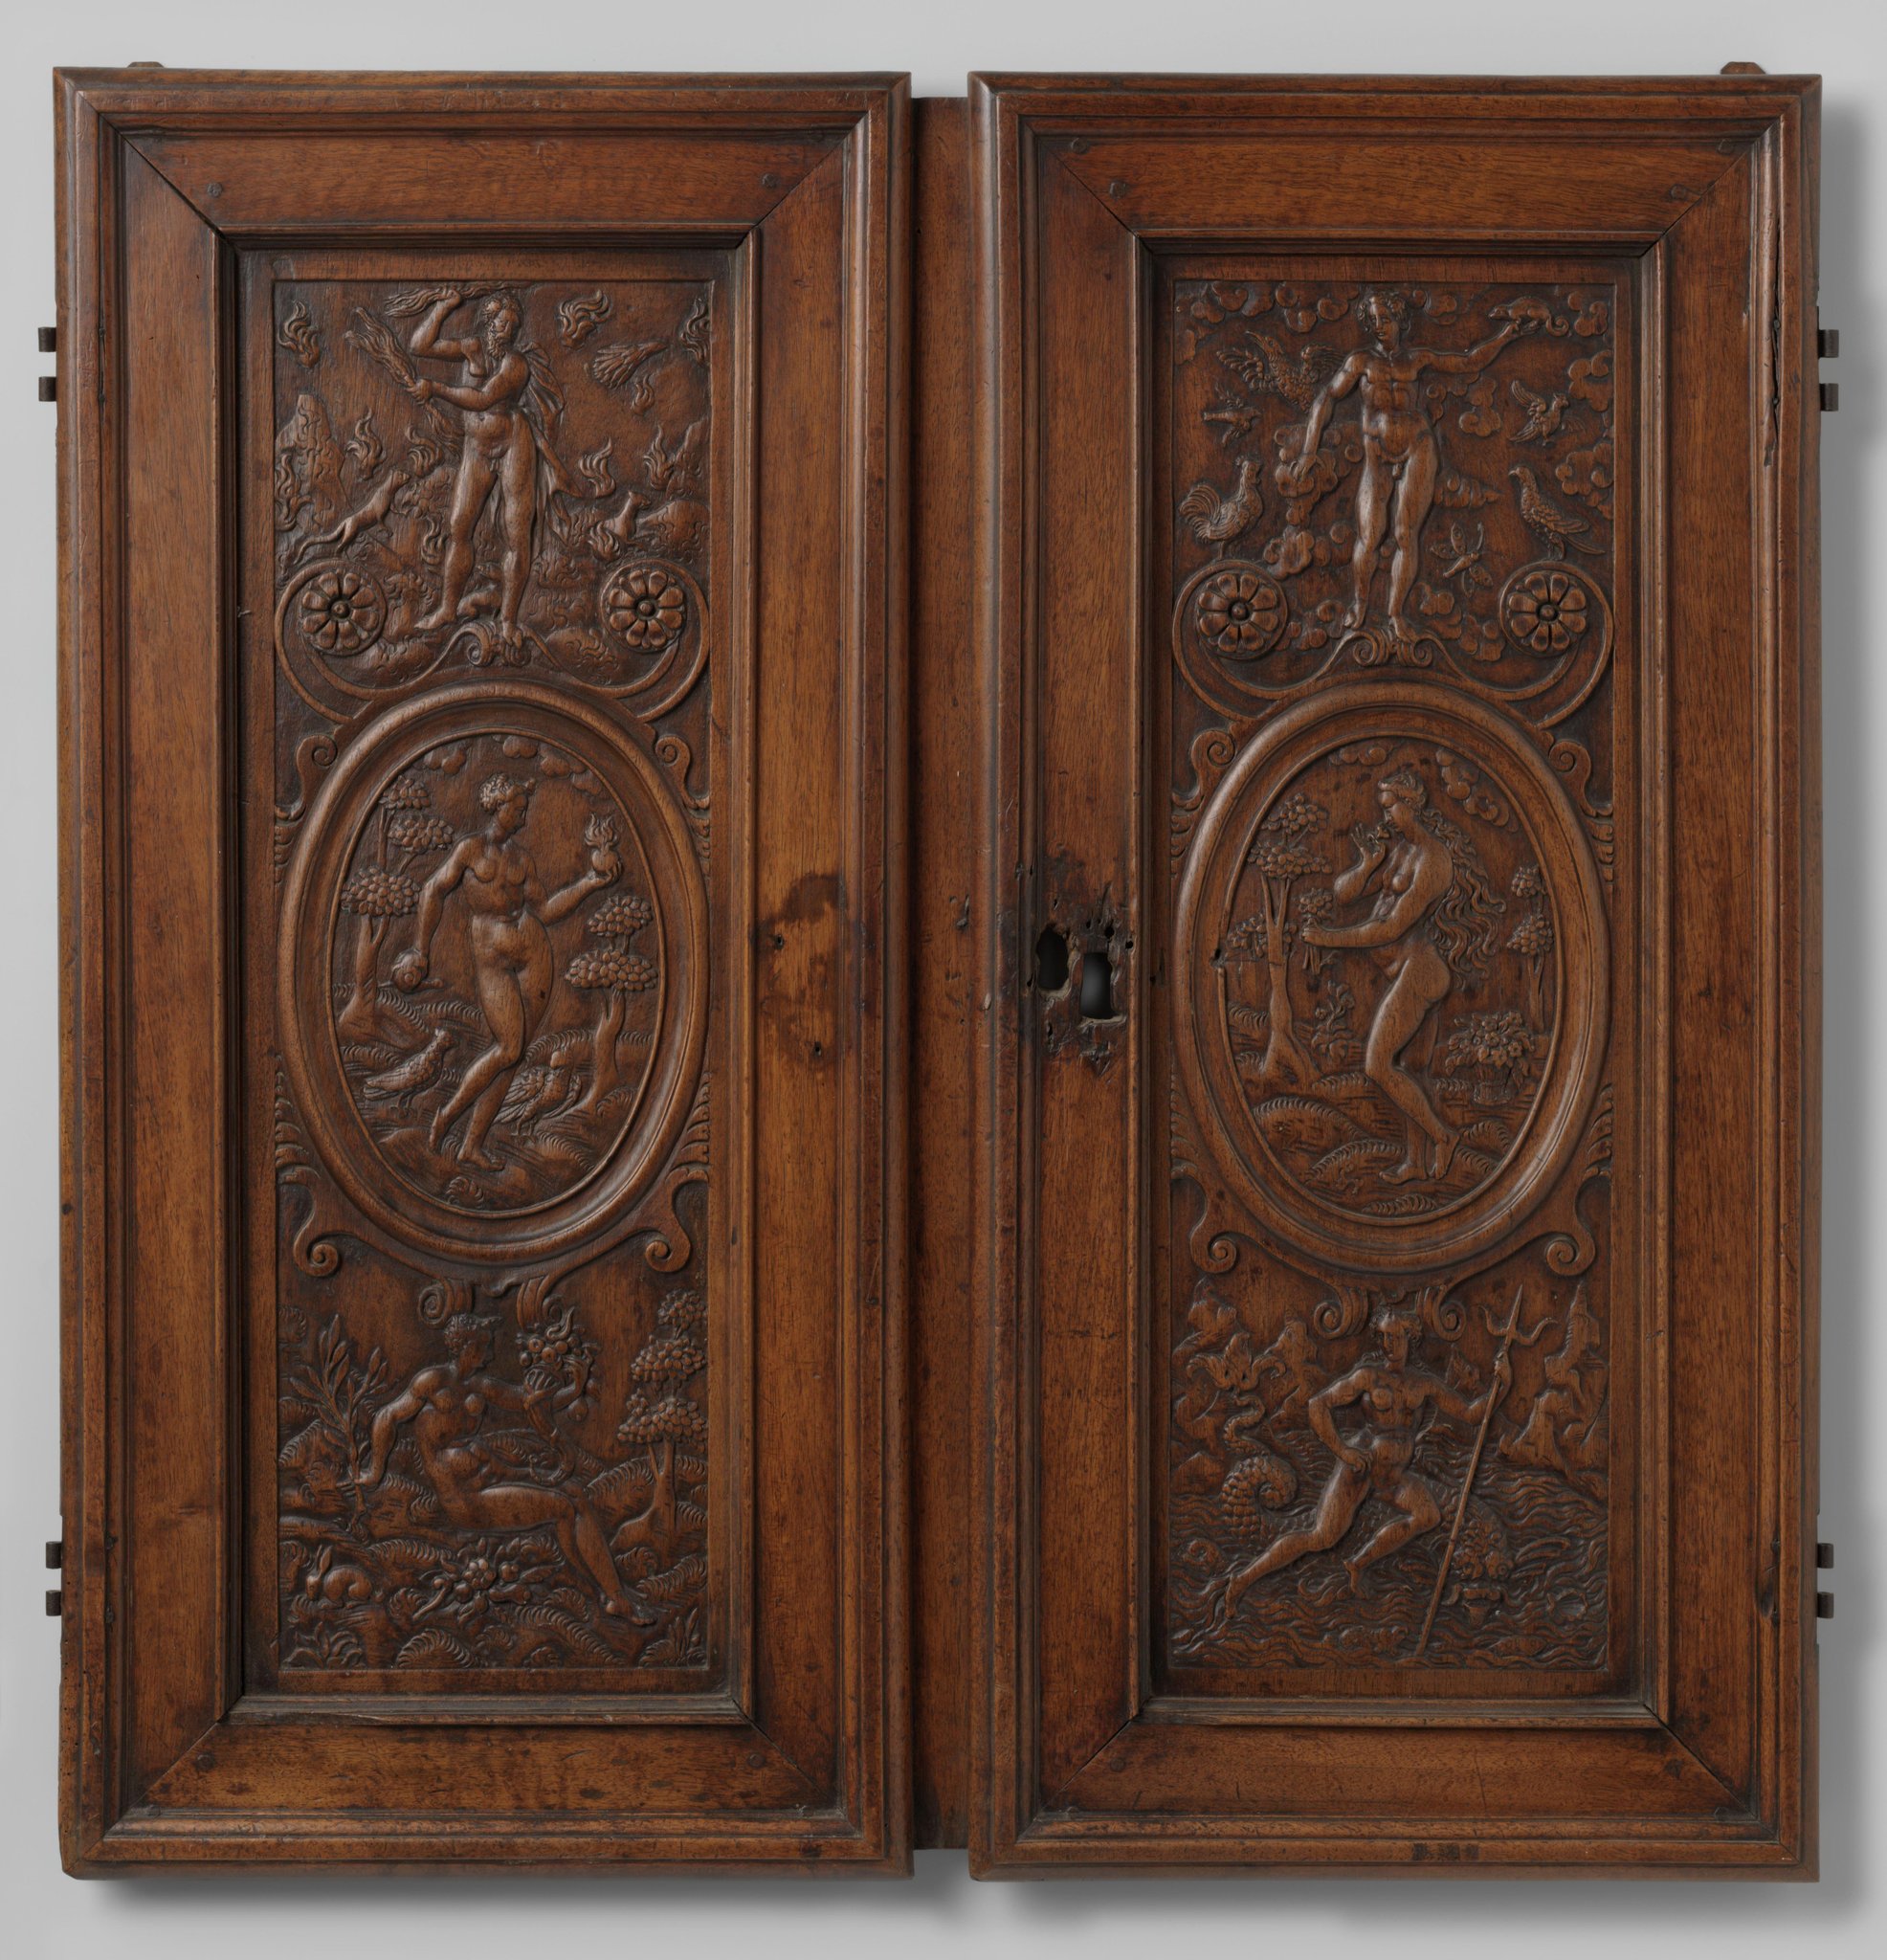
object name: kastdeur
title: Kastdeur met rolwerk en medaillons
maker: Anonymous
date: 1550-1600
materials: wood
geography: france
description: Kastdeur van notenhout (vermoedelijk van de bovenste helft van een kast). De deur is, binnen een geprofileerd raam, in vlak reliëf versierd met door rolwerk omgeven medaillons, versierd met allegorische figuren die de Reuk en het Gevoel (?) verbeelden. Boven en onder de medaillons worden door allegorische figuren de vier elementen voorgesteld. Zie tevens: BK-NM-12336-a.